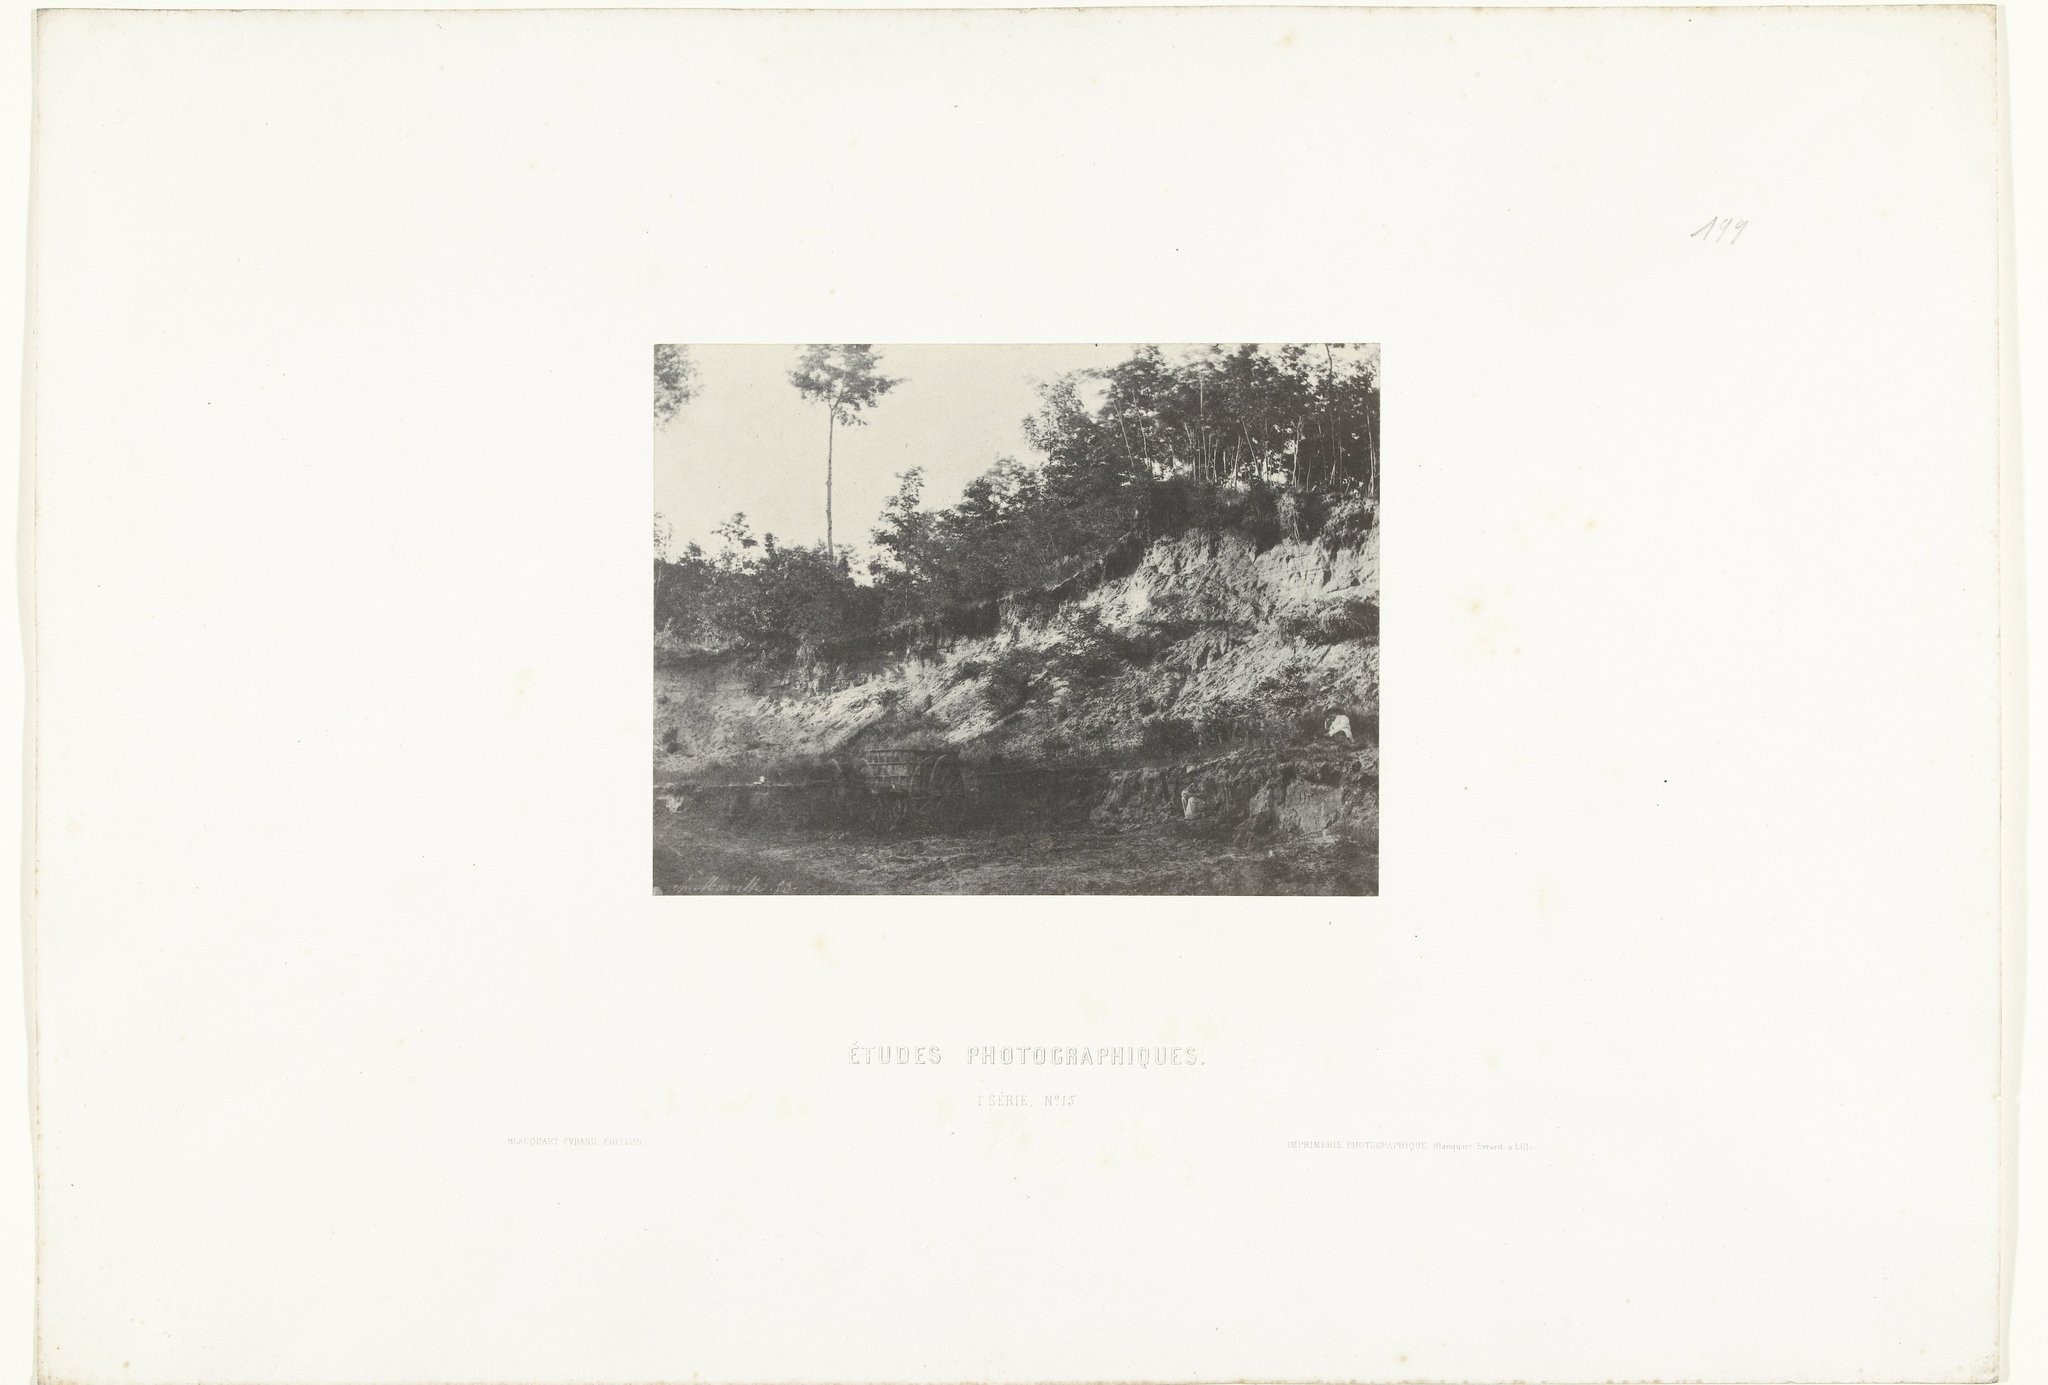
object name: photograph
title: Études Photographiques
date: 1853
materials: paper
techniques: salted paper print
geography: lille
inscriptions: title: ‘ÉTUDES PHOTOGRAPHIQUES 1' SÉRIE, No15’, annotation: ‘BLANQUART ÉVRARD, EDITEUR’, number: ‘199’, signature: ‘Ch. Marville. 53.’, annotation: ‘IMPRIMERIE PHOTOGRAPHIQUE, Blanquart-Evrard, à Lille.’